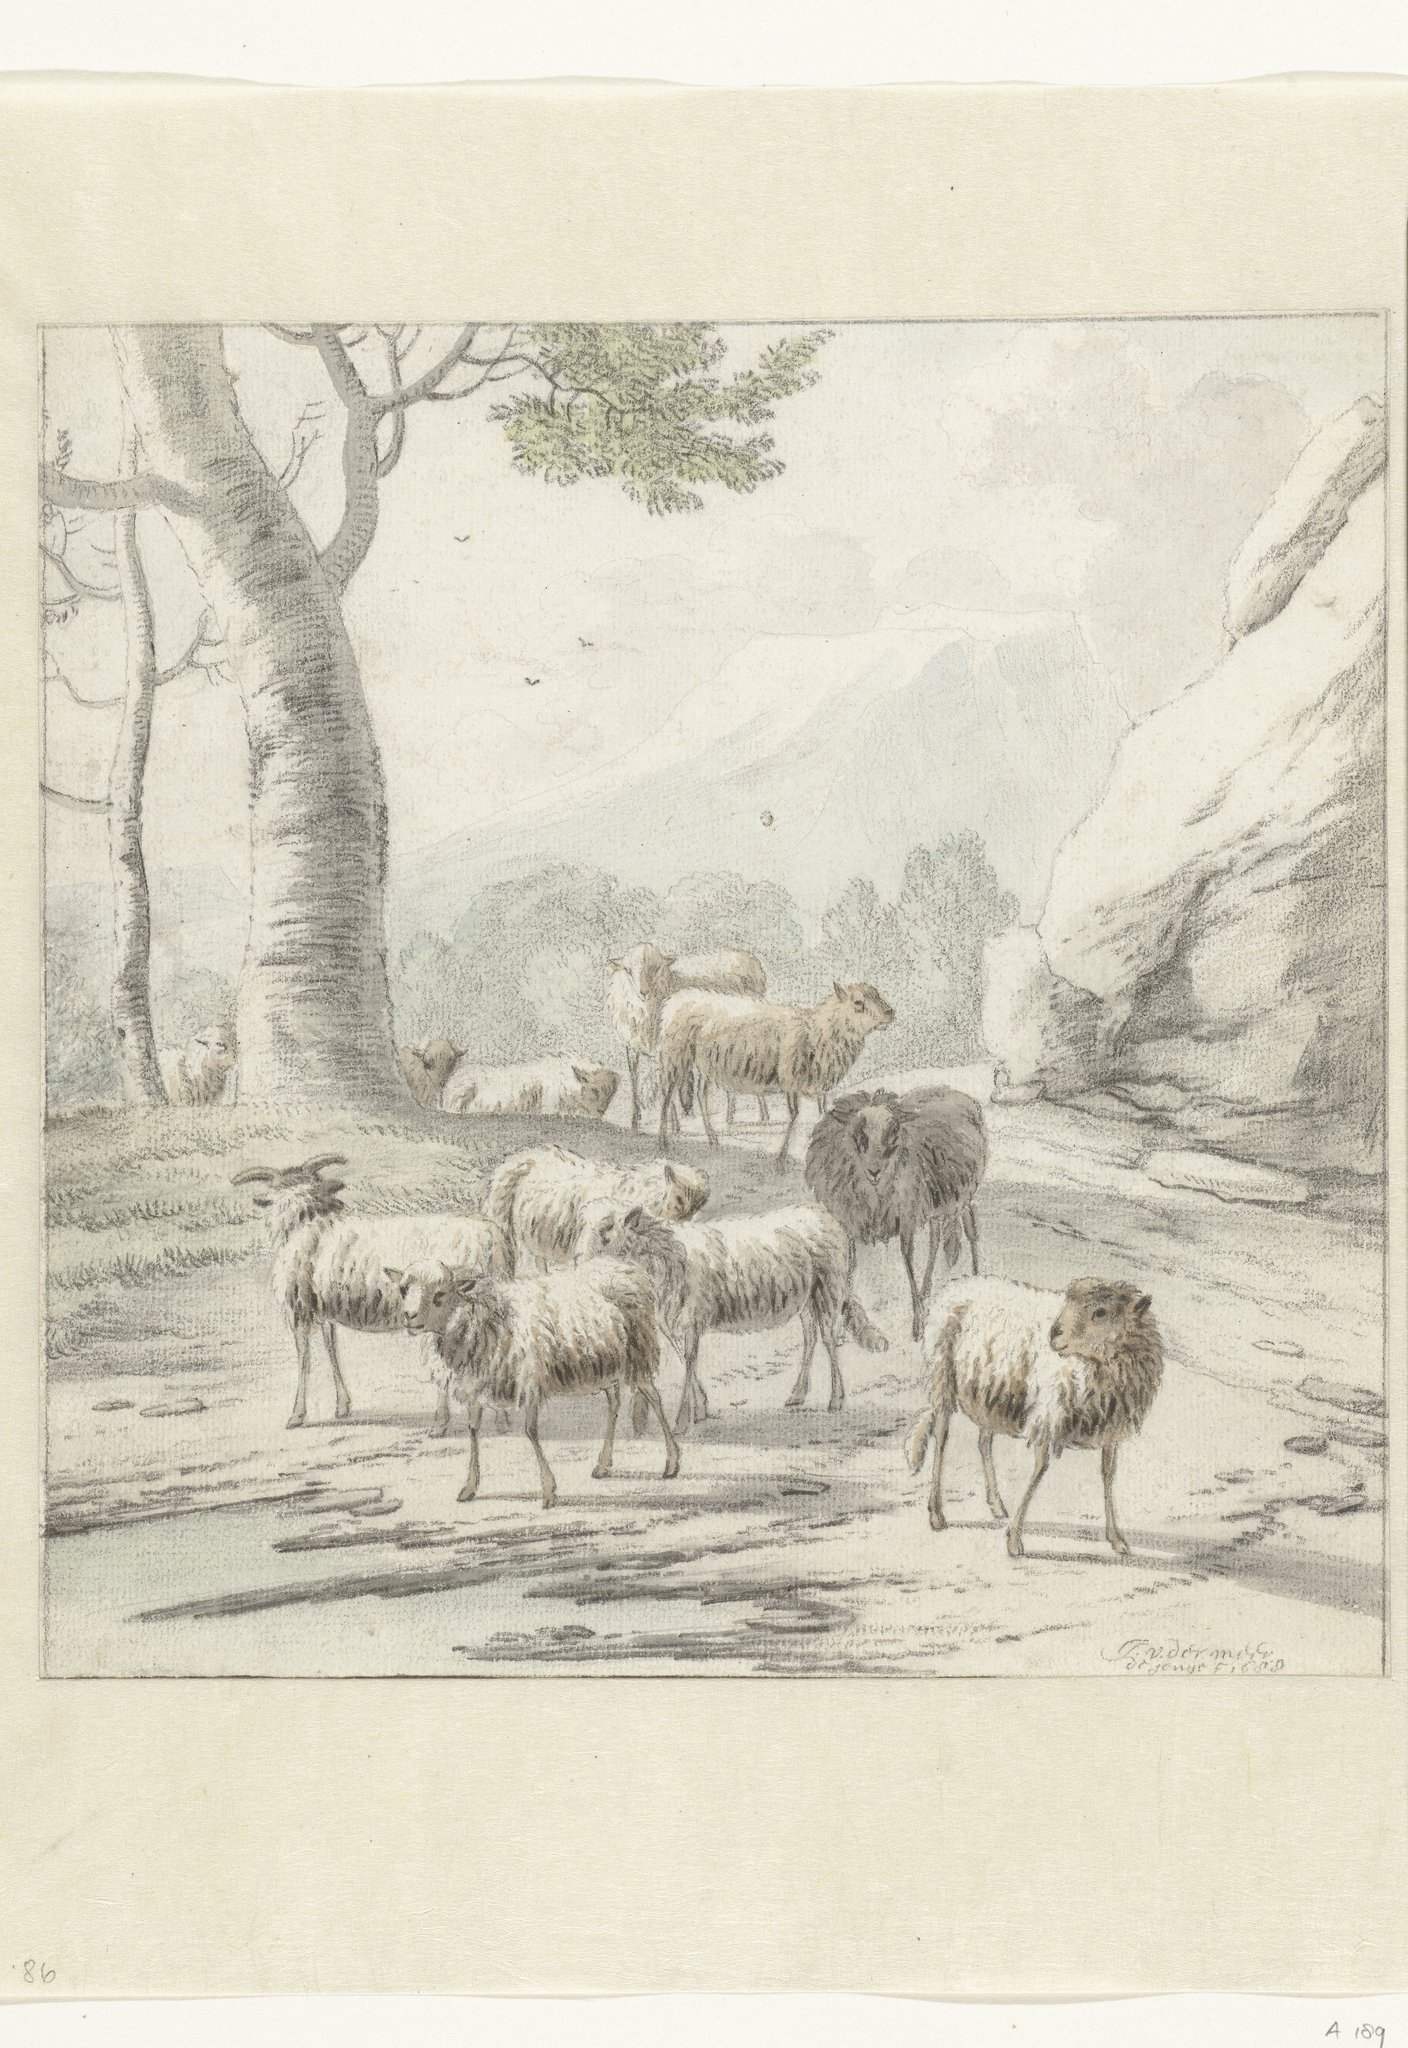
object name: drawing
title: Landscape with a Flock of Sheep near a Tree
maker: jan van der meer (ii)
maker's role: draughtsman, print maker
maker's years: 1656-1705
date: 1688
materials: chalk, paper, watercolor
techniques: brush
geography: haarlem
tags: sheep